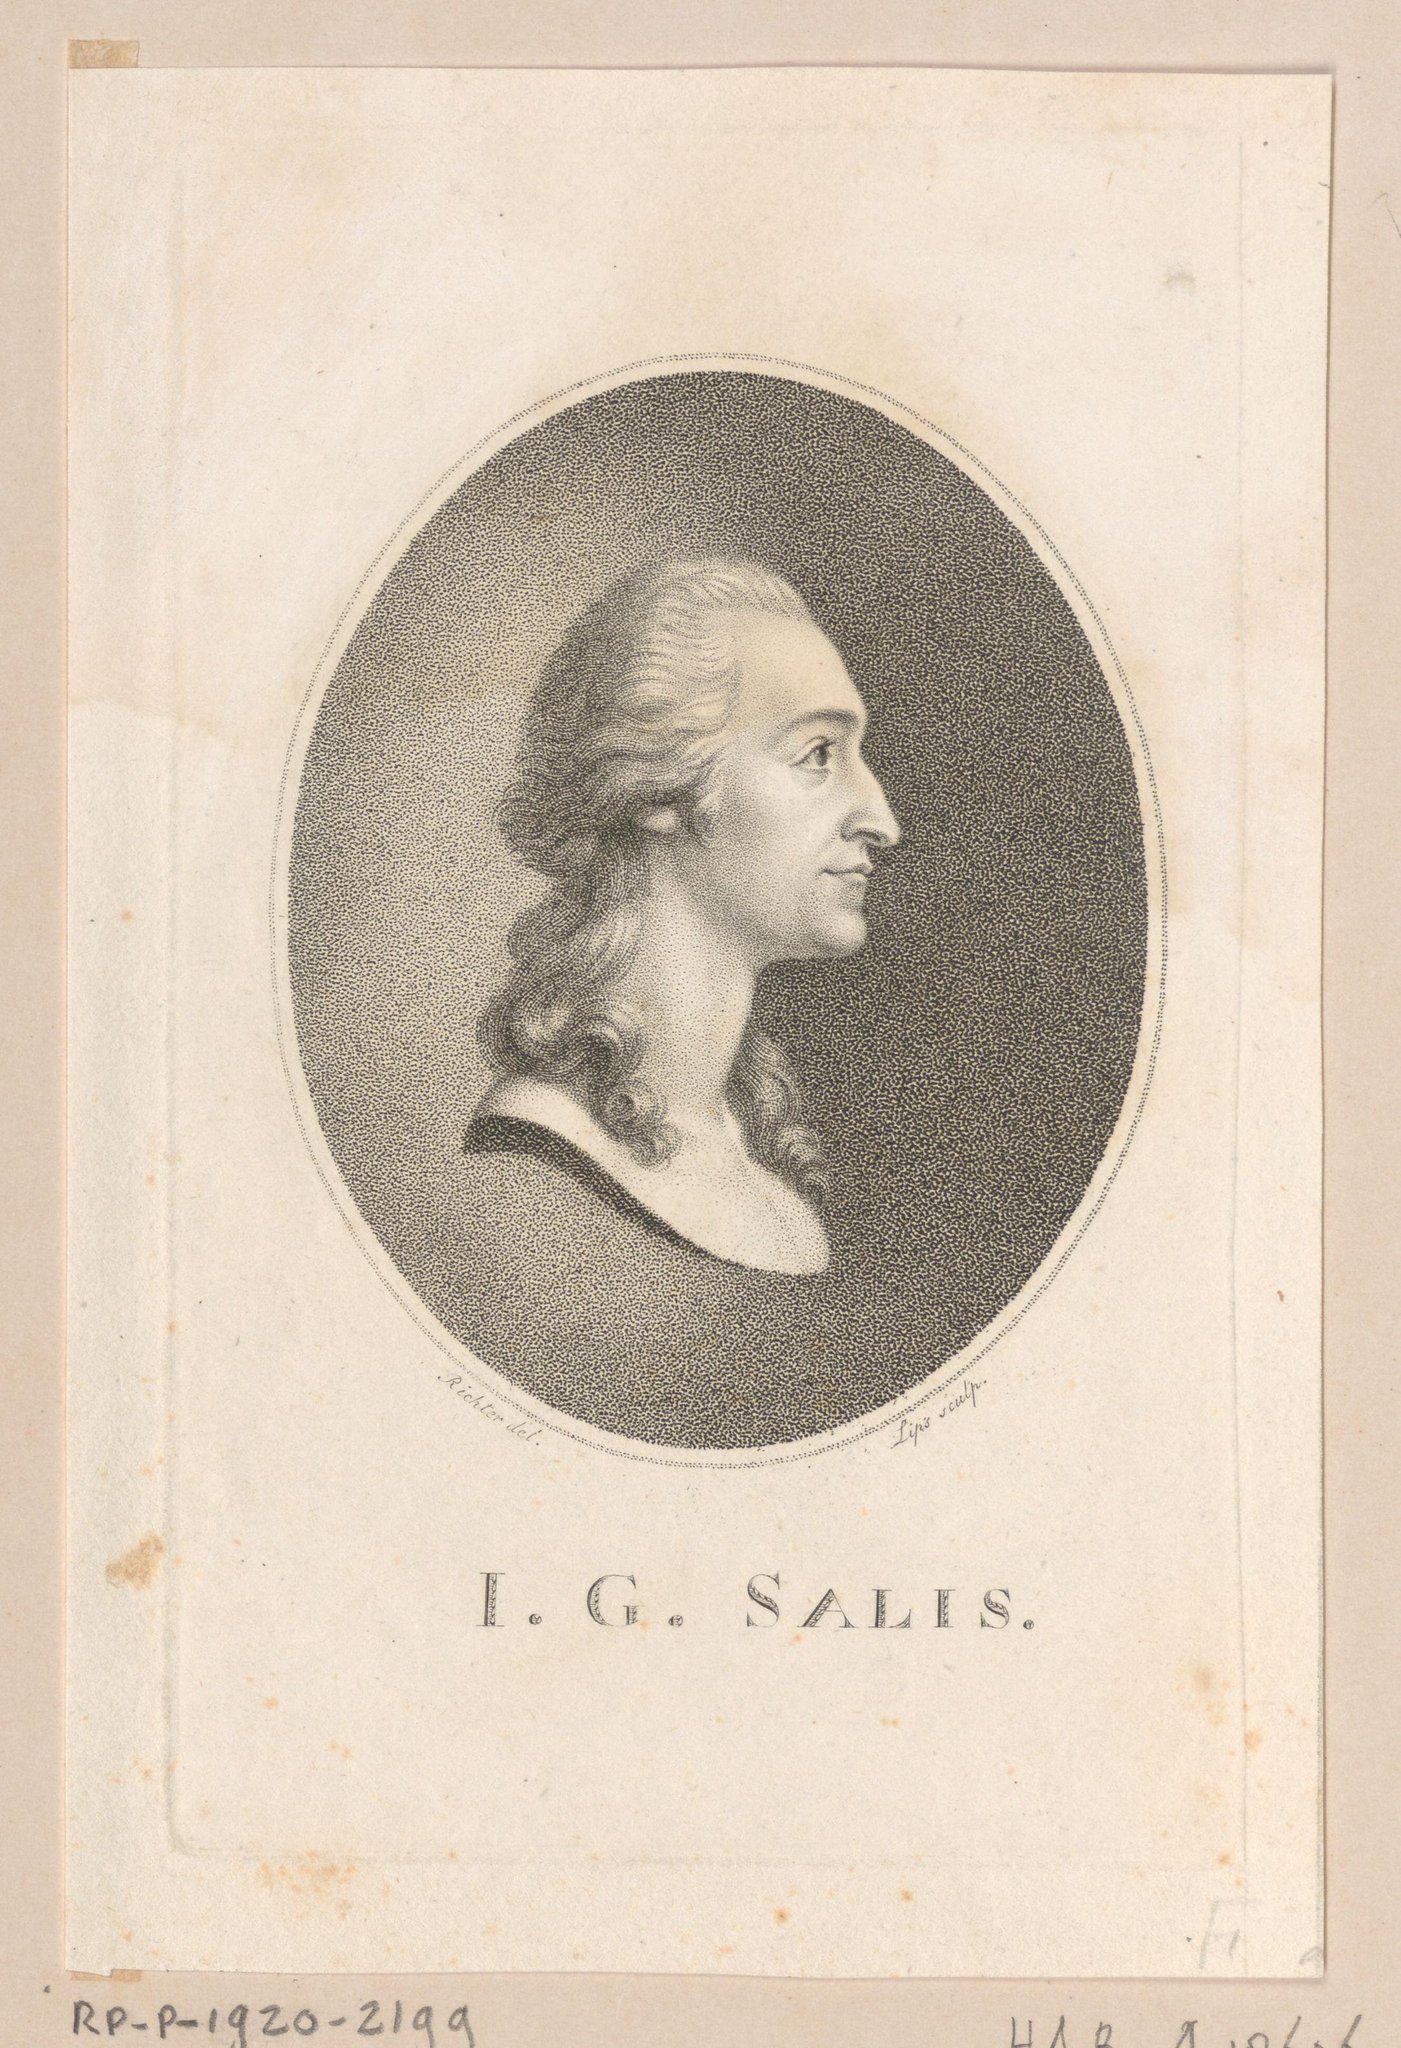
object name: print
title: Portret van Johann Gaudenz, Freiherr von Salis-Seewis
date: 1800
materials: paper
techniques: engraving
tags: historical persons, politician, e.g. party leader, writer, poet, author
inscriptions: collector's mark: Lugt 2228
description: Prent waarschijnlijk uit: Salis-Seewis, Johann Gaudenz Freiherr von. Gedichte. Zürich: Orell Füßli und Companie, 1800.